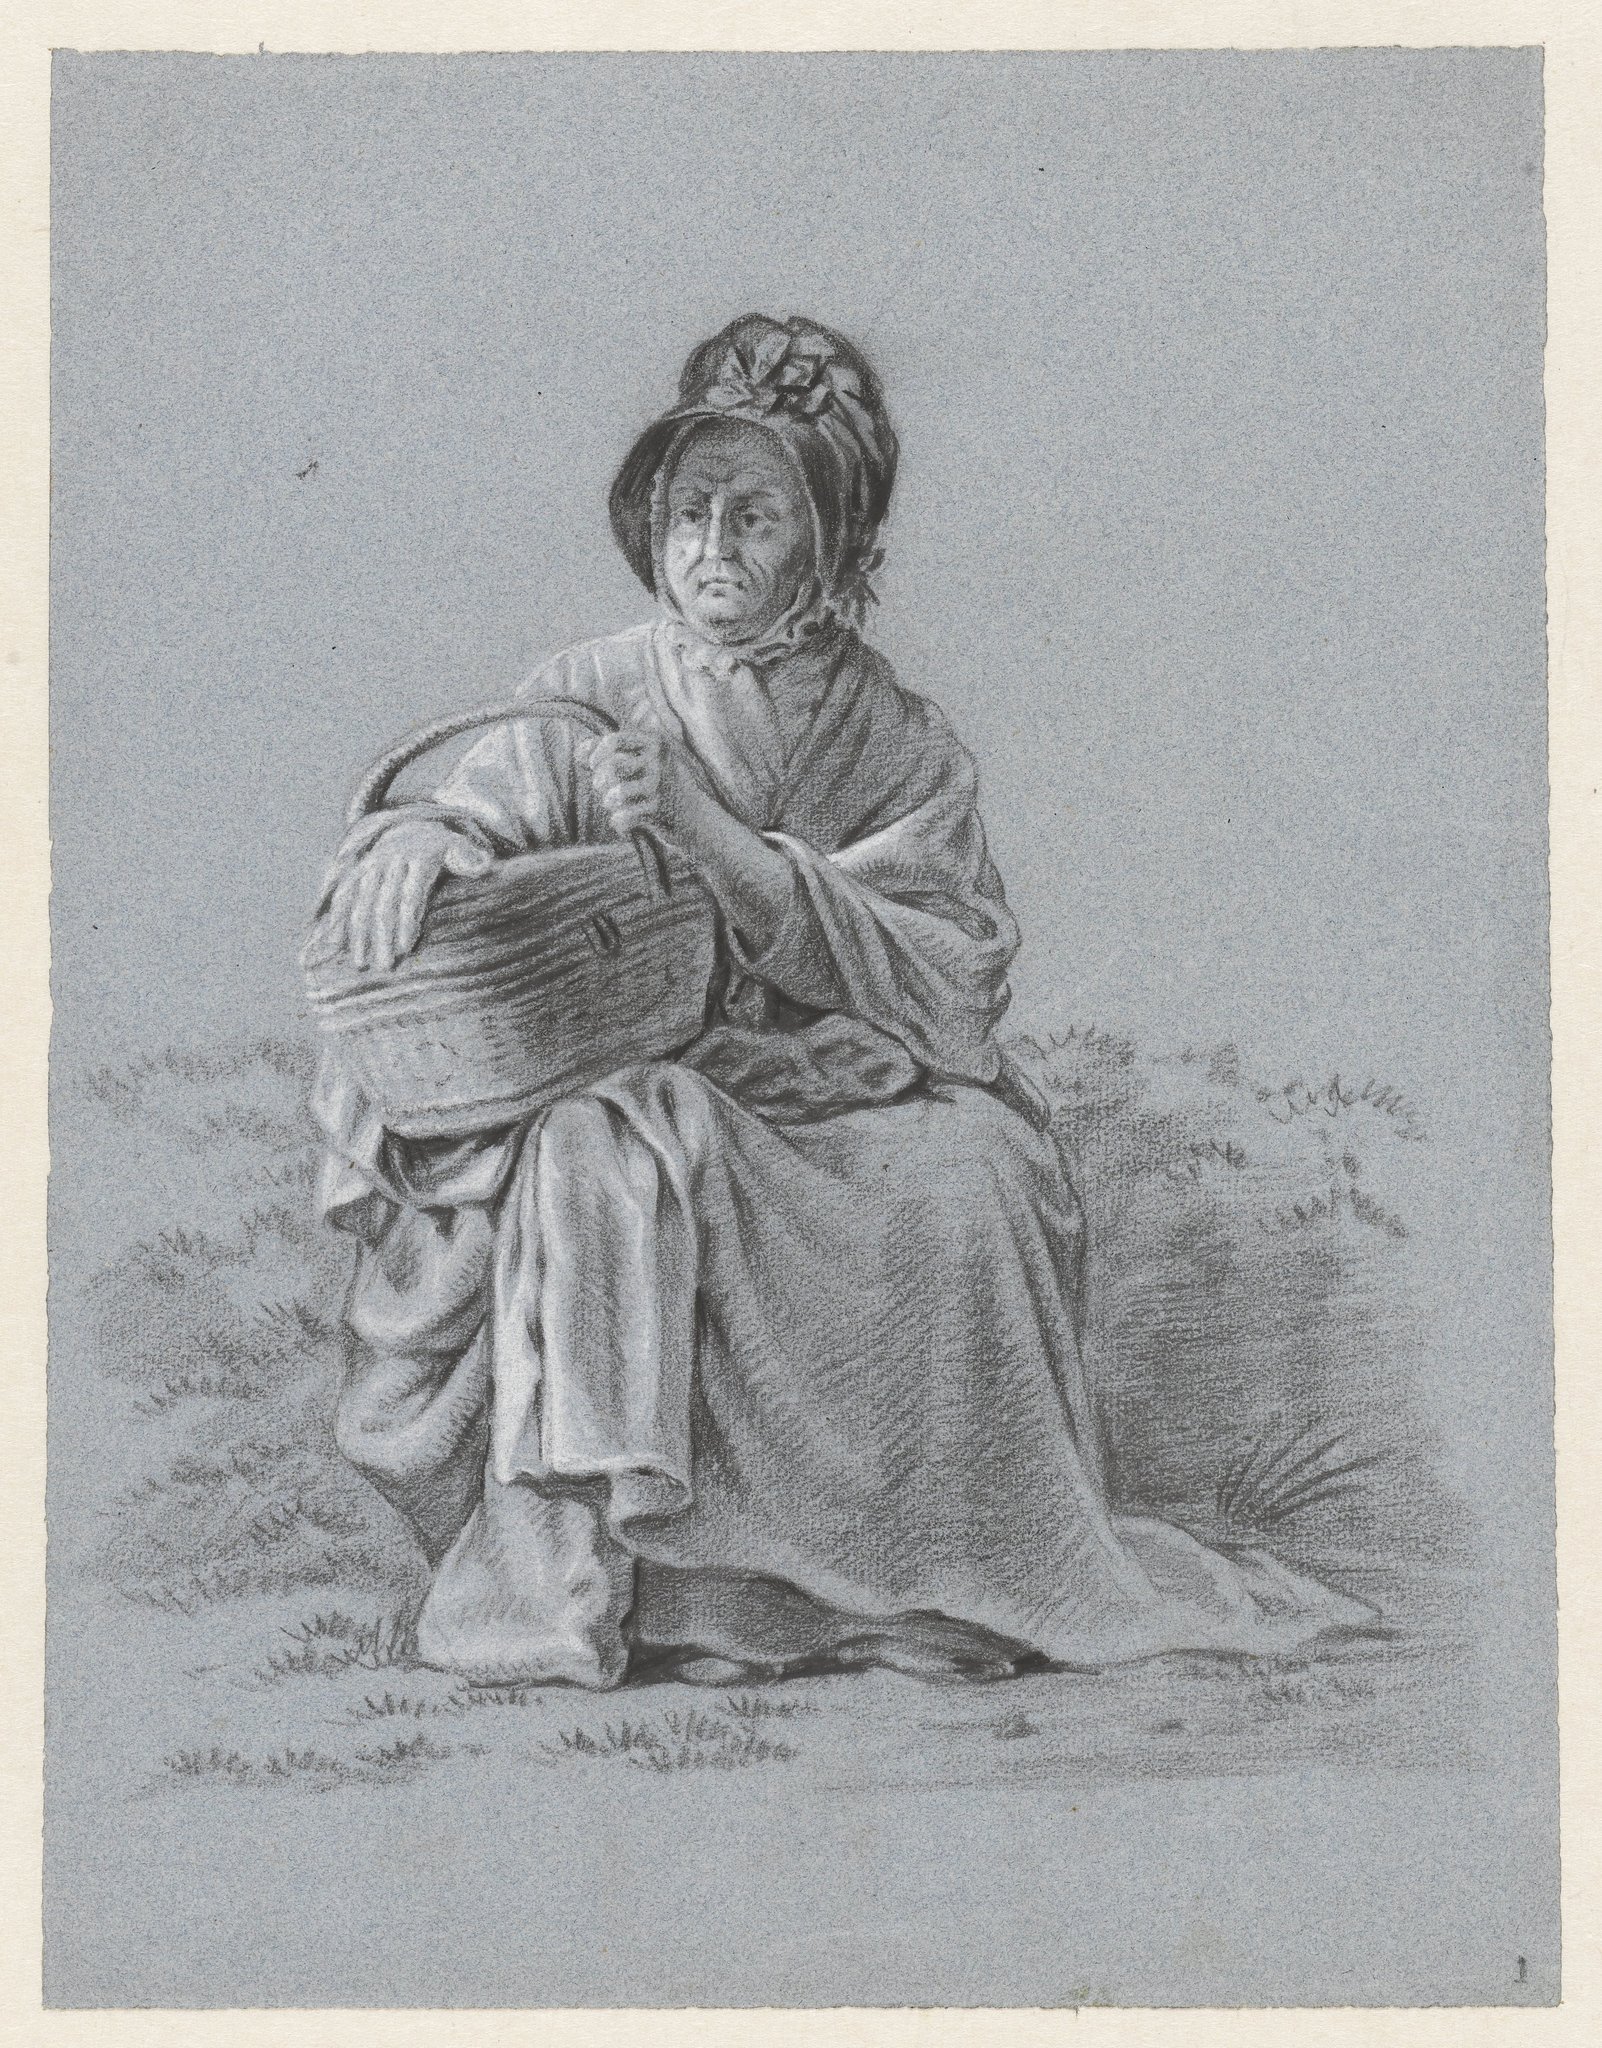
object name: drawing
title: Zittende oude vrouw met een mand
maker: pieter bartholomeusz. barbiers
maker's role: draughtsman, print maker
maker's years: 1772-1837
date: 1782-1837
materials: chalk, paint, paper